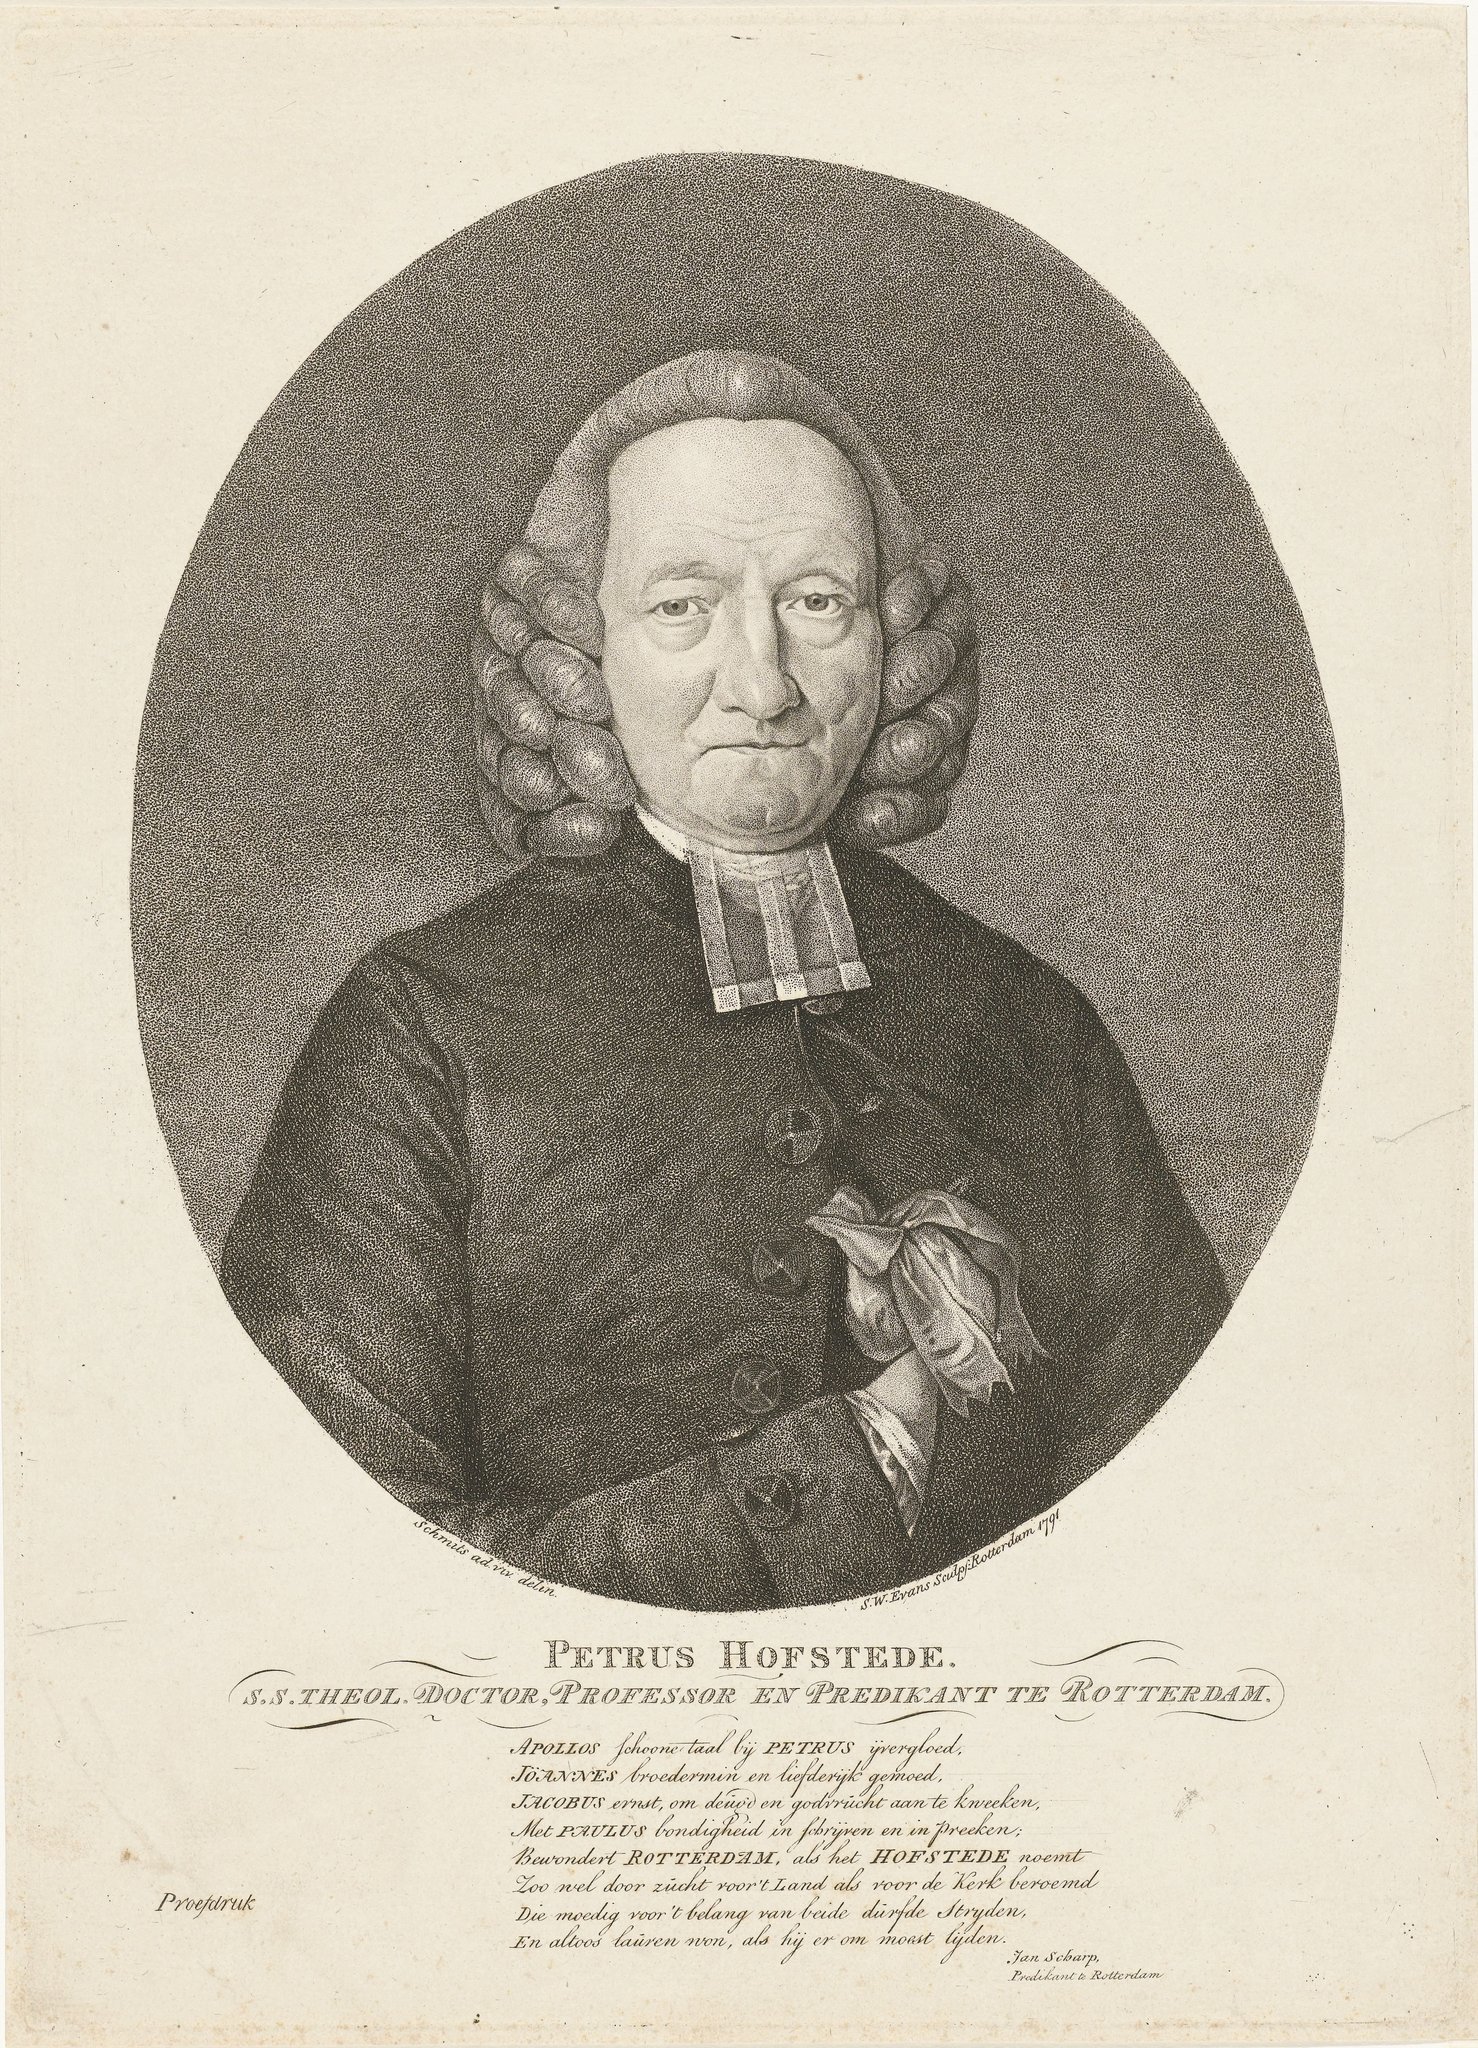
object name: print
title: Portret van Petrus Hofstede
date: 1791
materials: paper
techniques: stippled etching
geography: rotterdam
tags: rotterdam, petrus hofstede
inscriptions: collector's mark: Lugt 2228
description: Ovaal portret van Petrus Hofstede, predikant te Rotterdam, afgebeeld met zijn rechter hand op zijn borst. Onder de voorstelling zijn naam en titel en een Nederlands vers van acht regels.